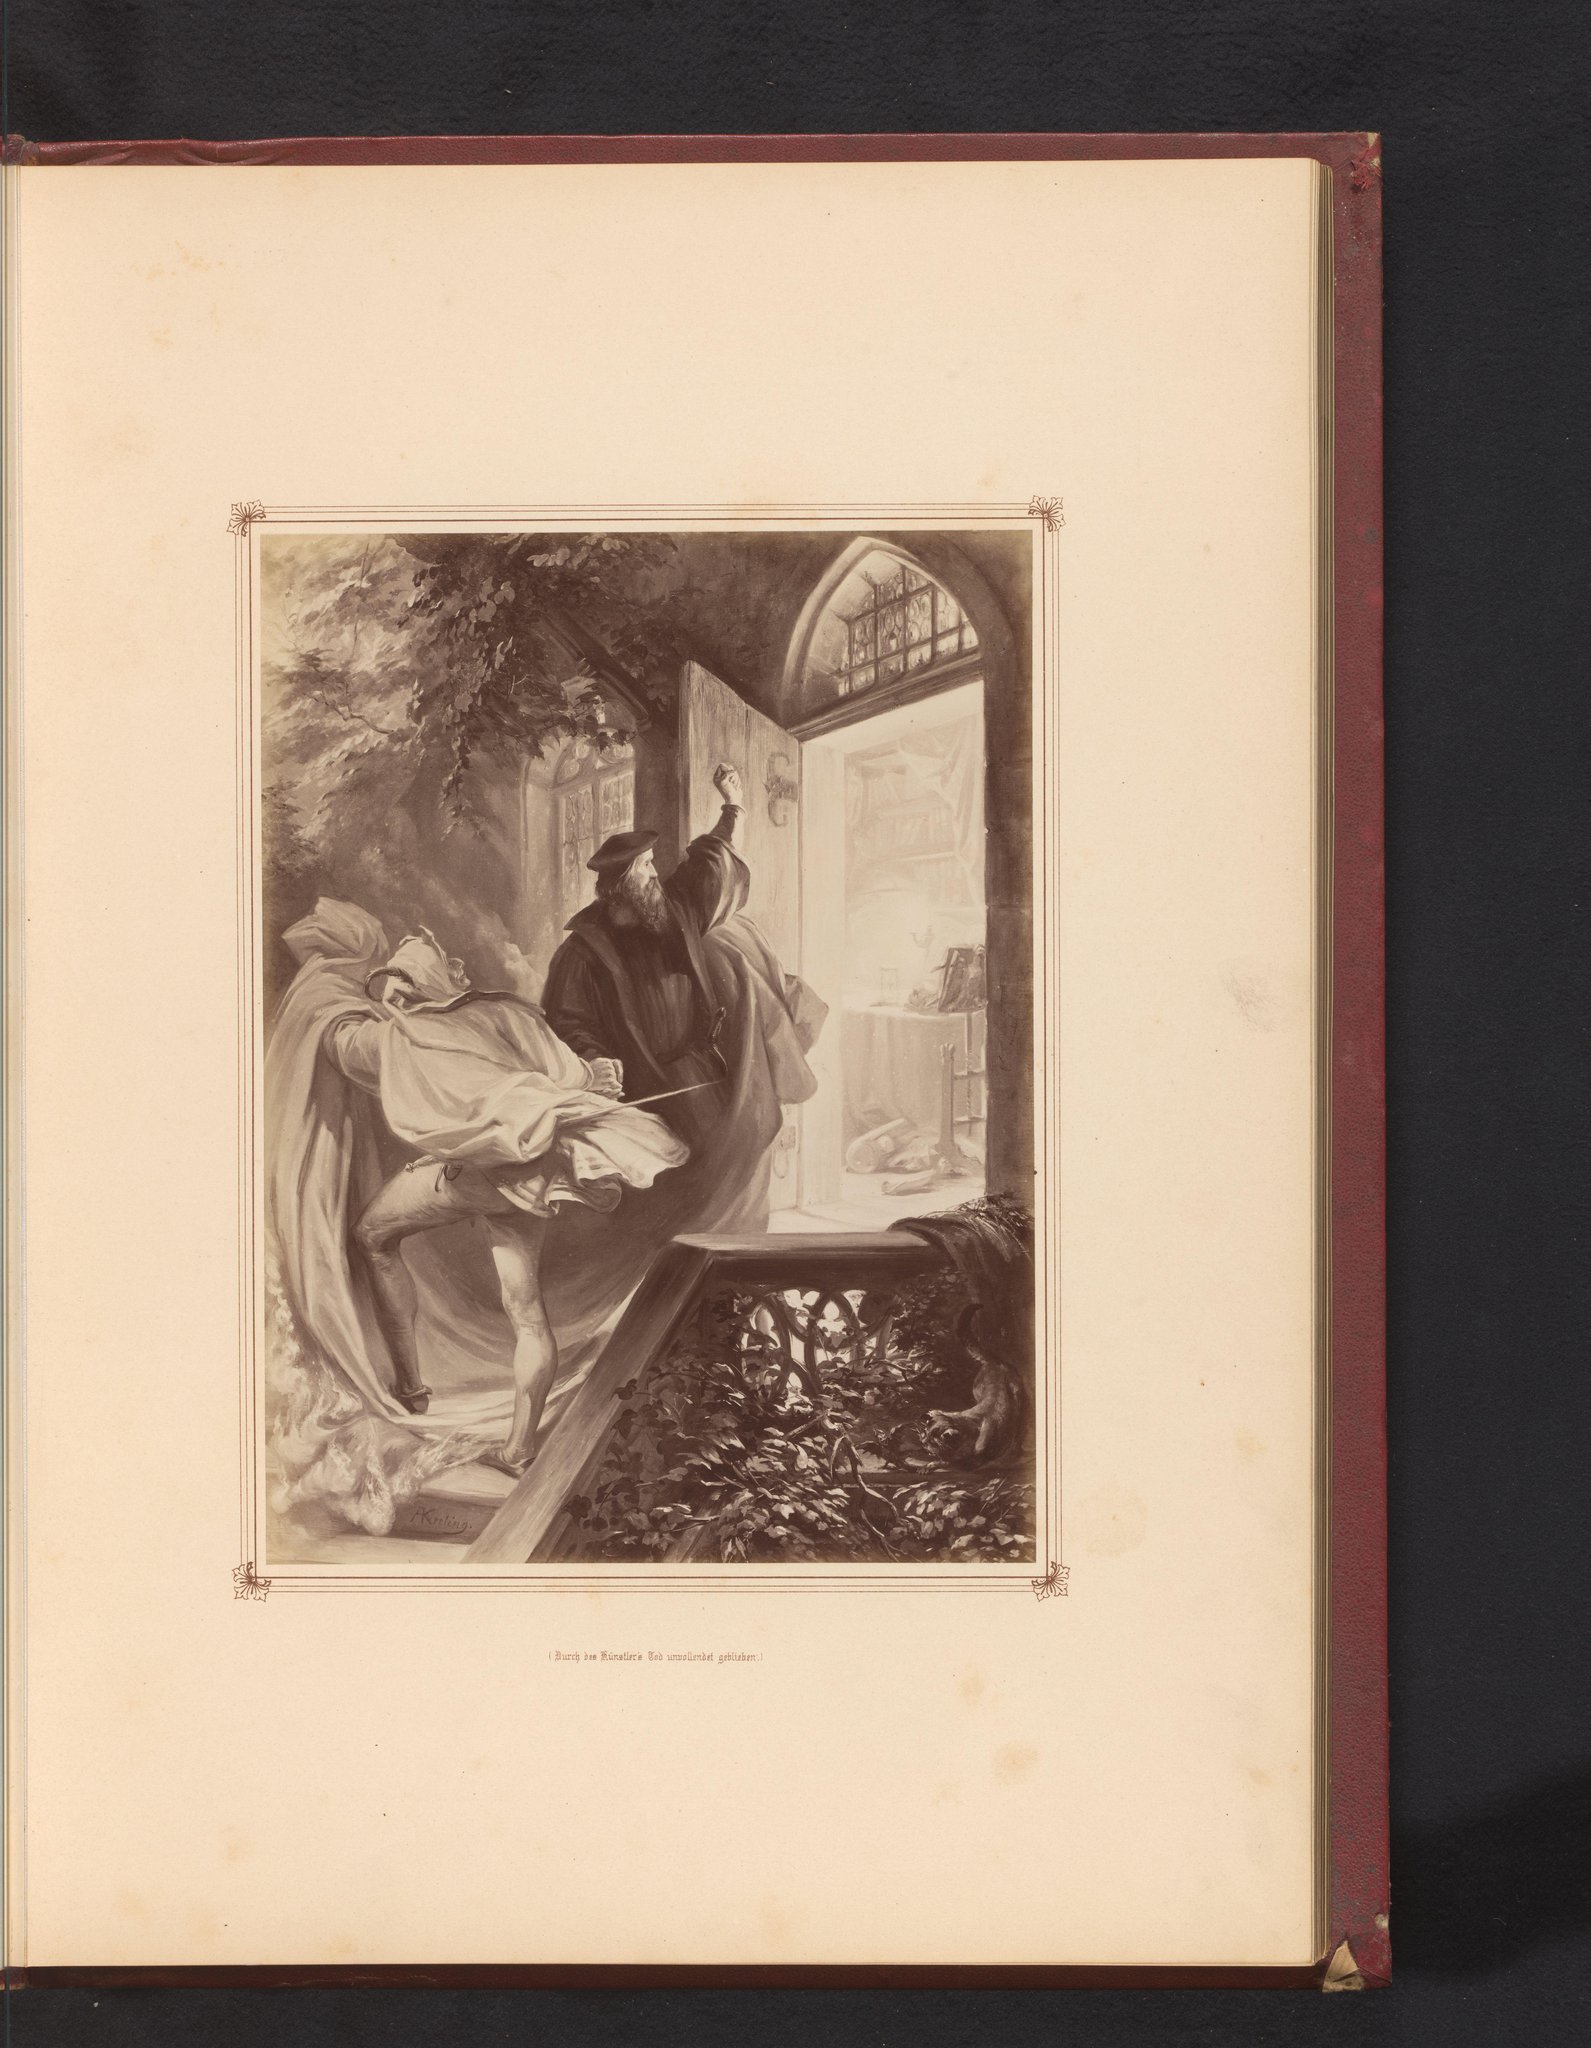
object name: photograph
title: Fotoreproductie van een tekening van Mephistopheles en Faust, uit het eerste deel van de tragedie Faust door Johann Wolfgang von Goethe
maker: friedrich bruckmann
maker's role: publisher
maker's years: 1814-1898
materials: photographic support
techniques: albumen print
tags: mephistopheles, name of the demonic tempter in the literary versions of the faust legends, (scenes from) specific works of literature: goethe, faust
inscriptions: inscription: ‘(Durch des Künstler's Tod unvollendet geblieben.)’